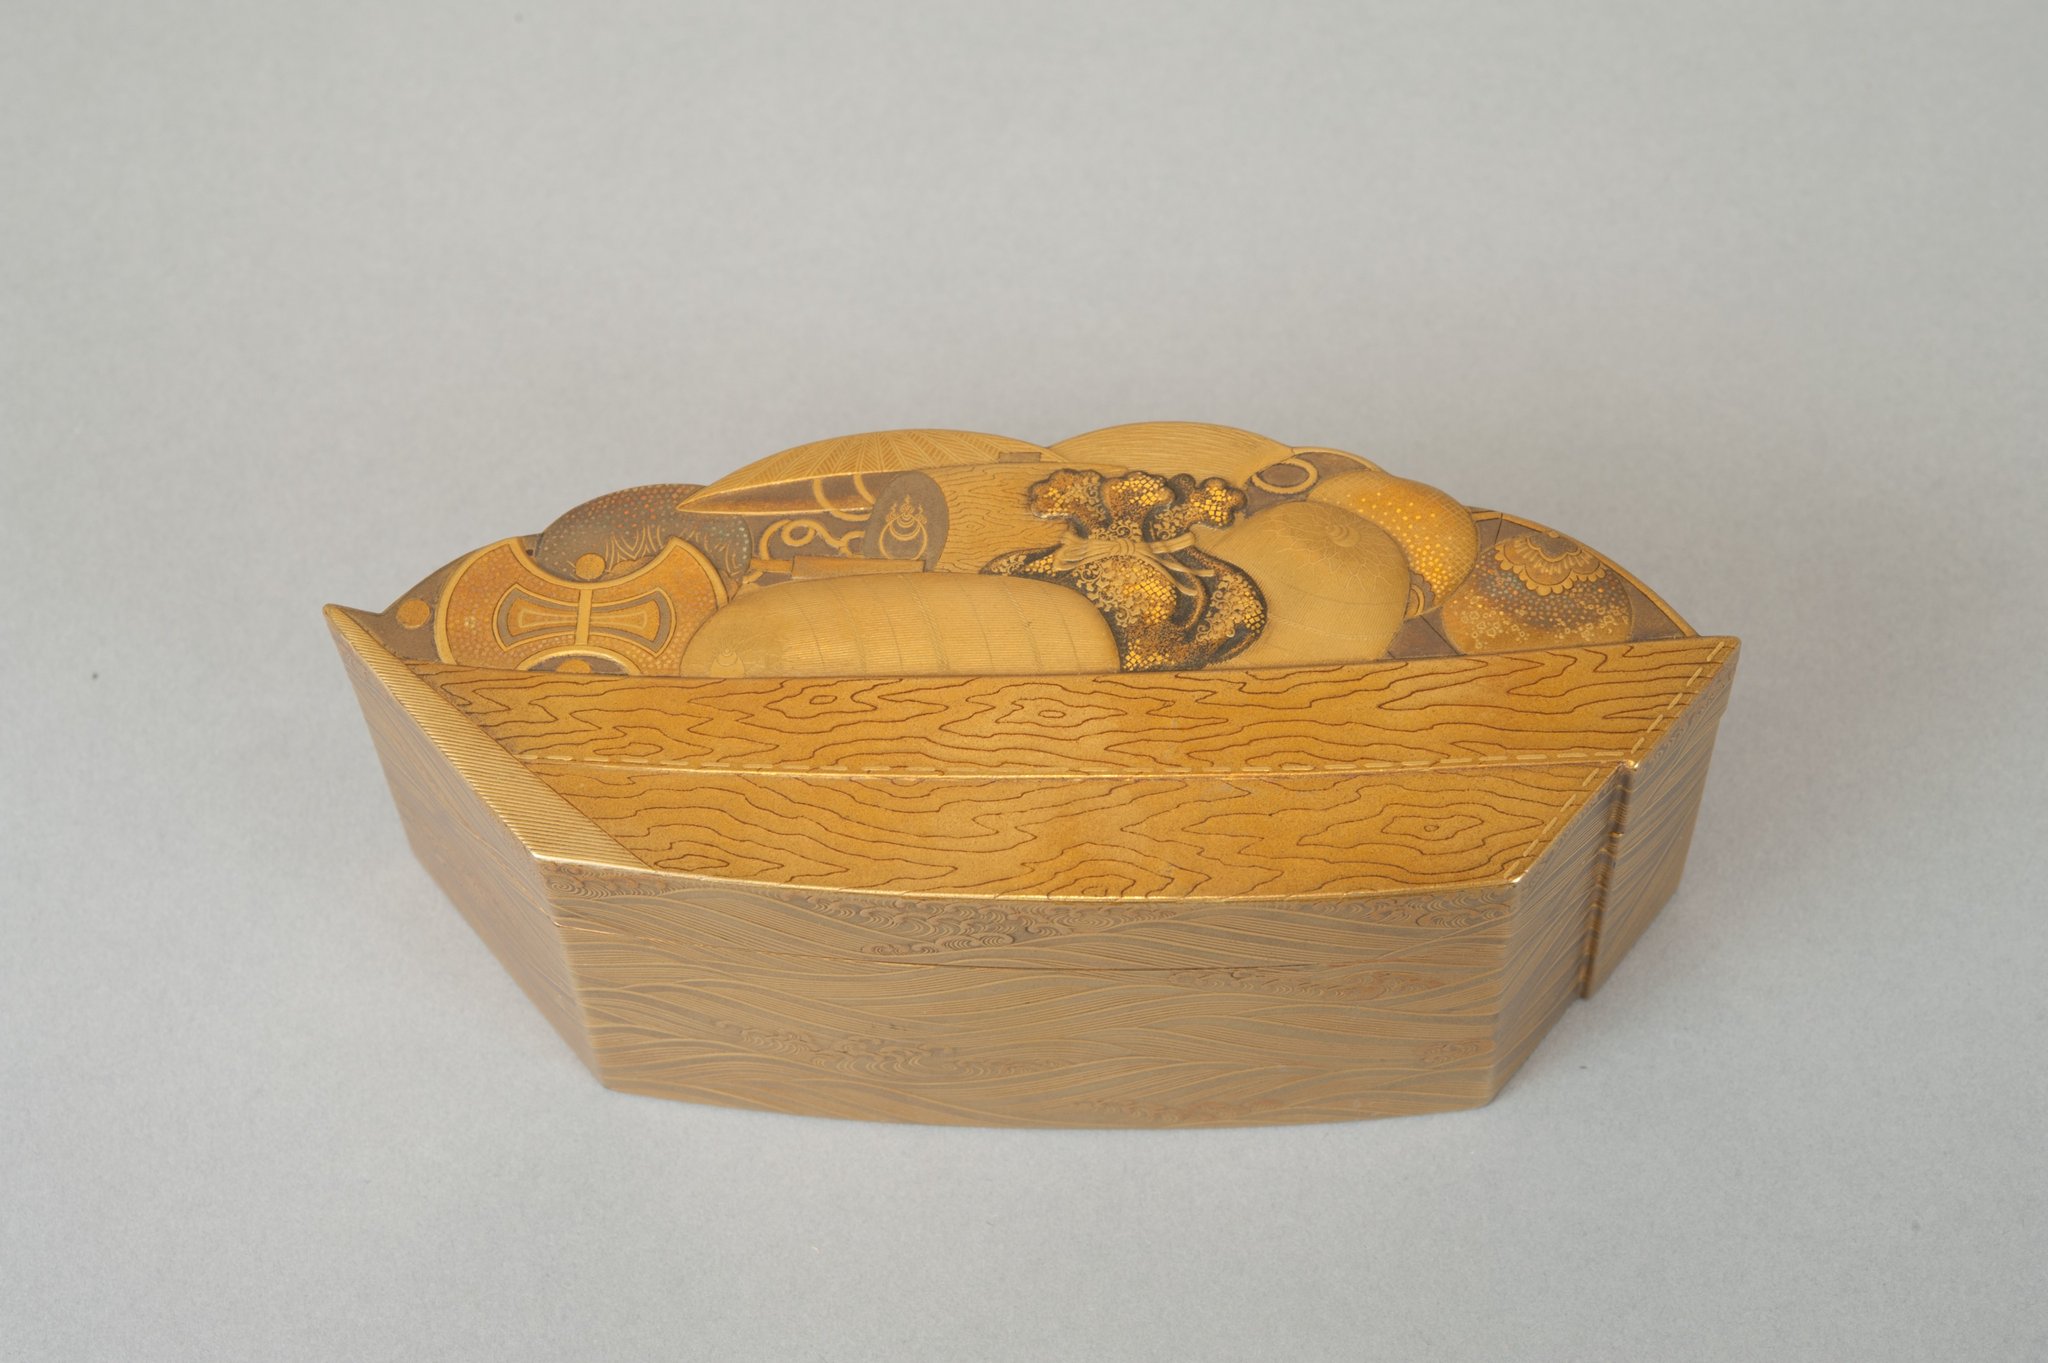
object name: incense box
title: Treasure Boat-shaped Incense Box [Kōgō]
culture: japanese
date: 1601-1700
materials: gold, lacquer, wood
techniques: lacquer, maki